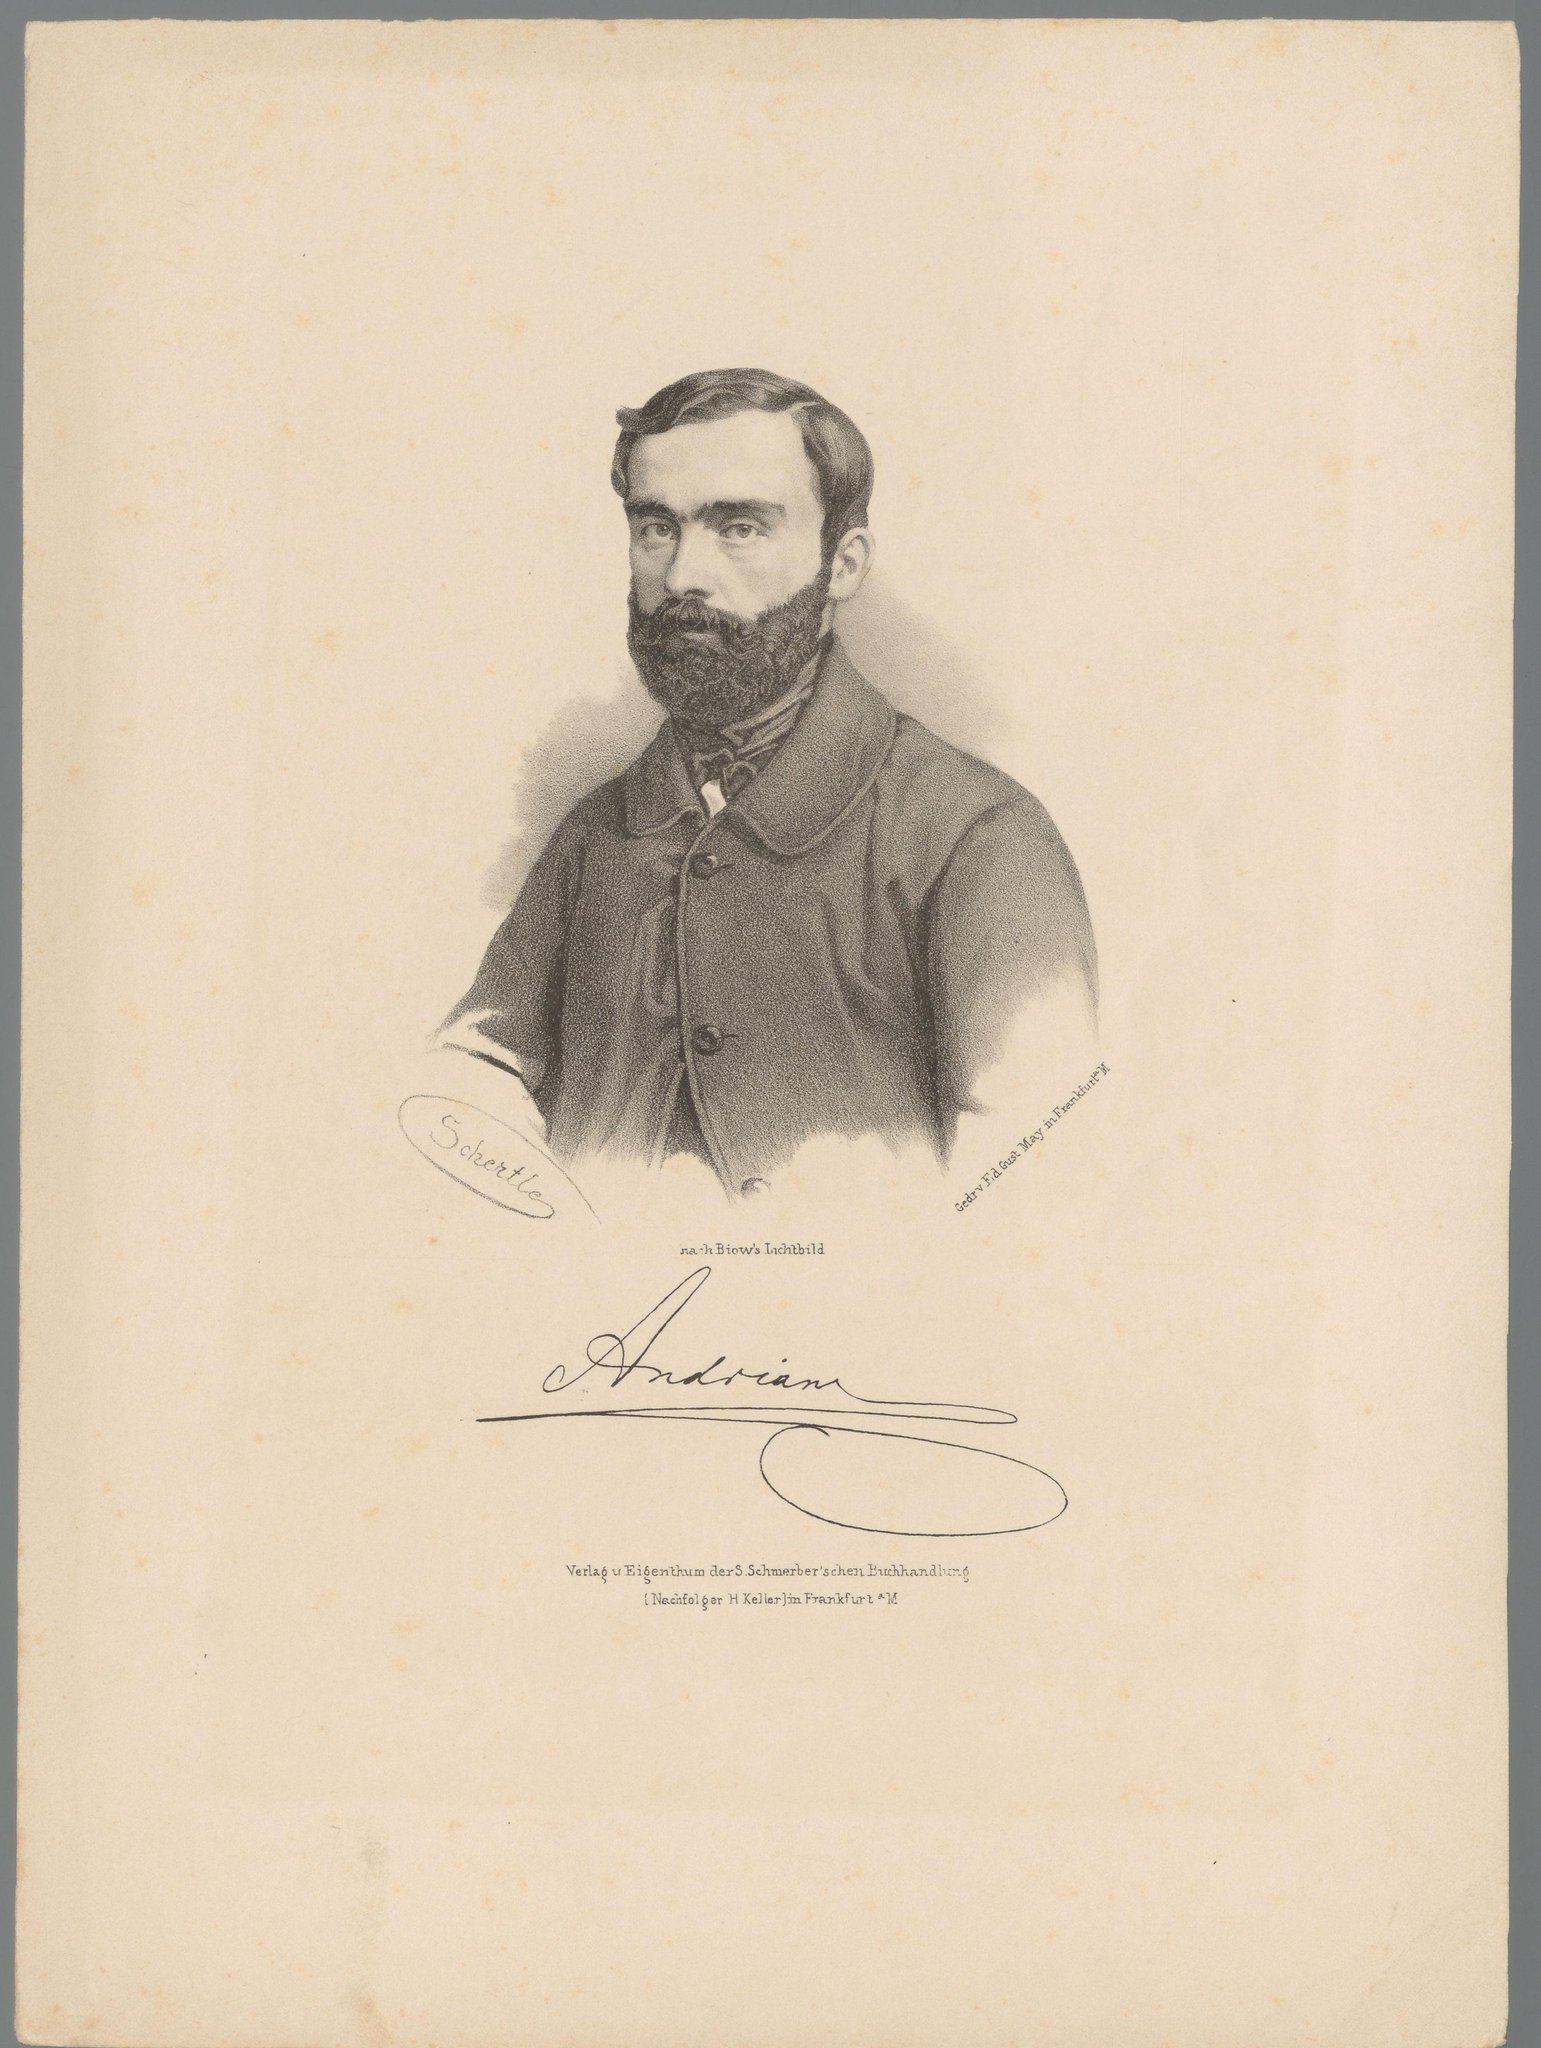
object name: print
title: Portret van Victor Franz von Andrian-Werburg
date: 1848-1849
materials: paper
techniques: lithograph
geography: frankfurt am main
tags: politician, adult man, historical persons, beard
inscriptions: collector's mark: Lugt 2228